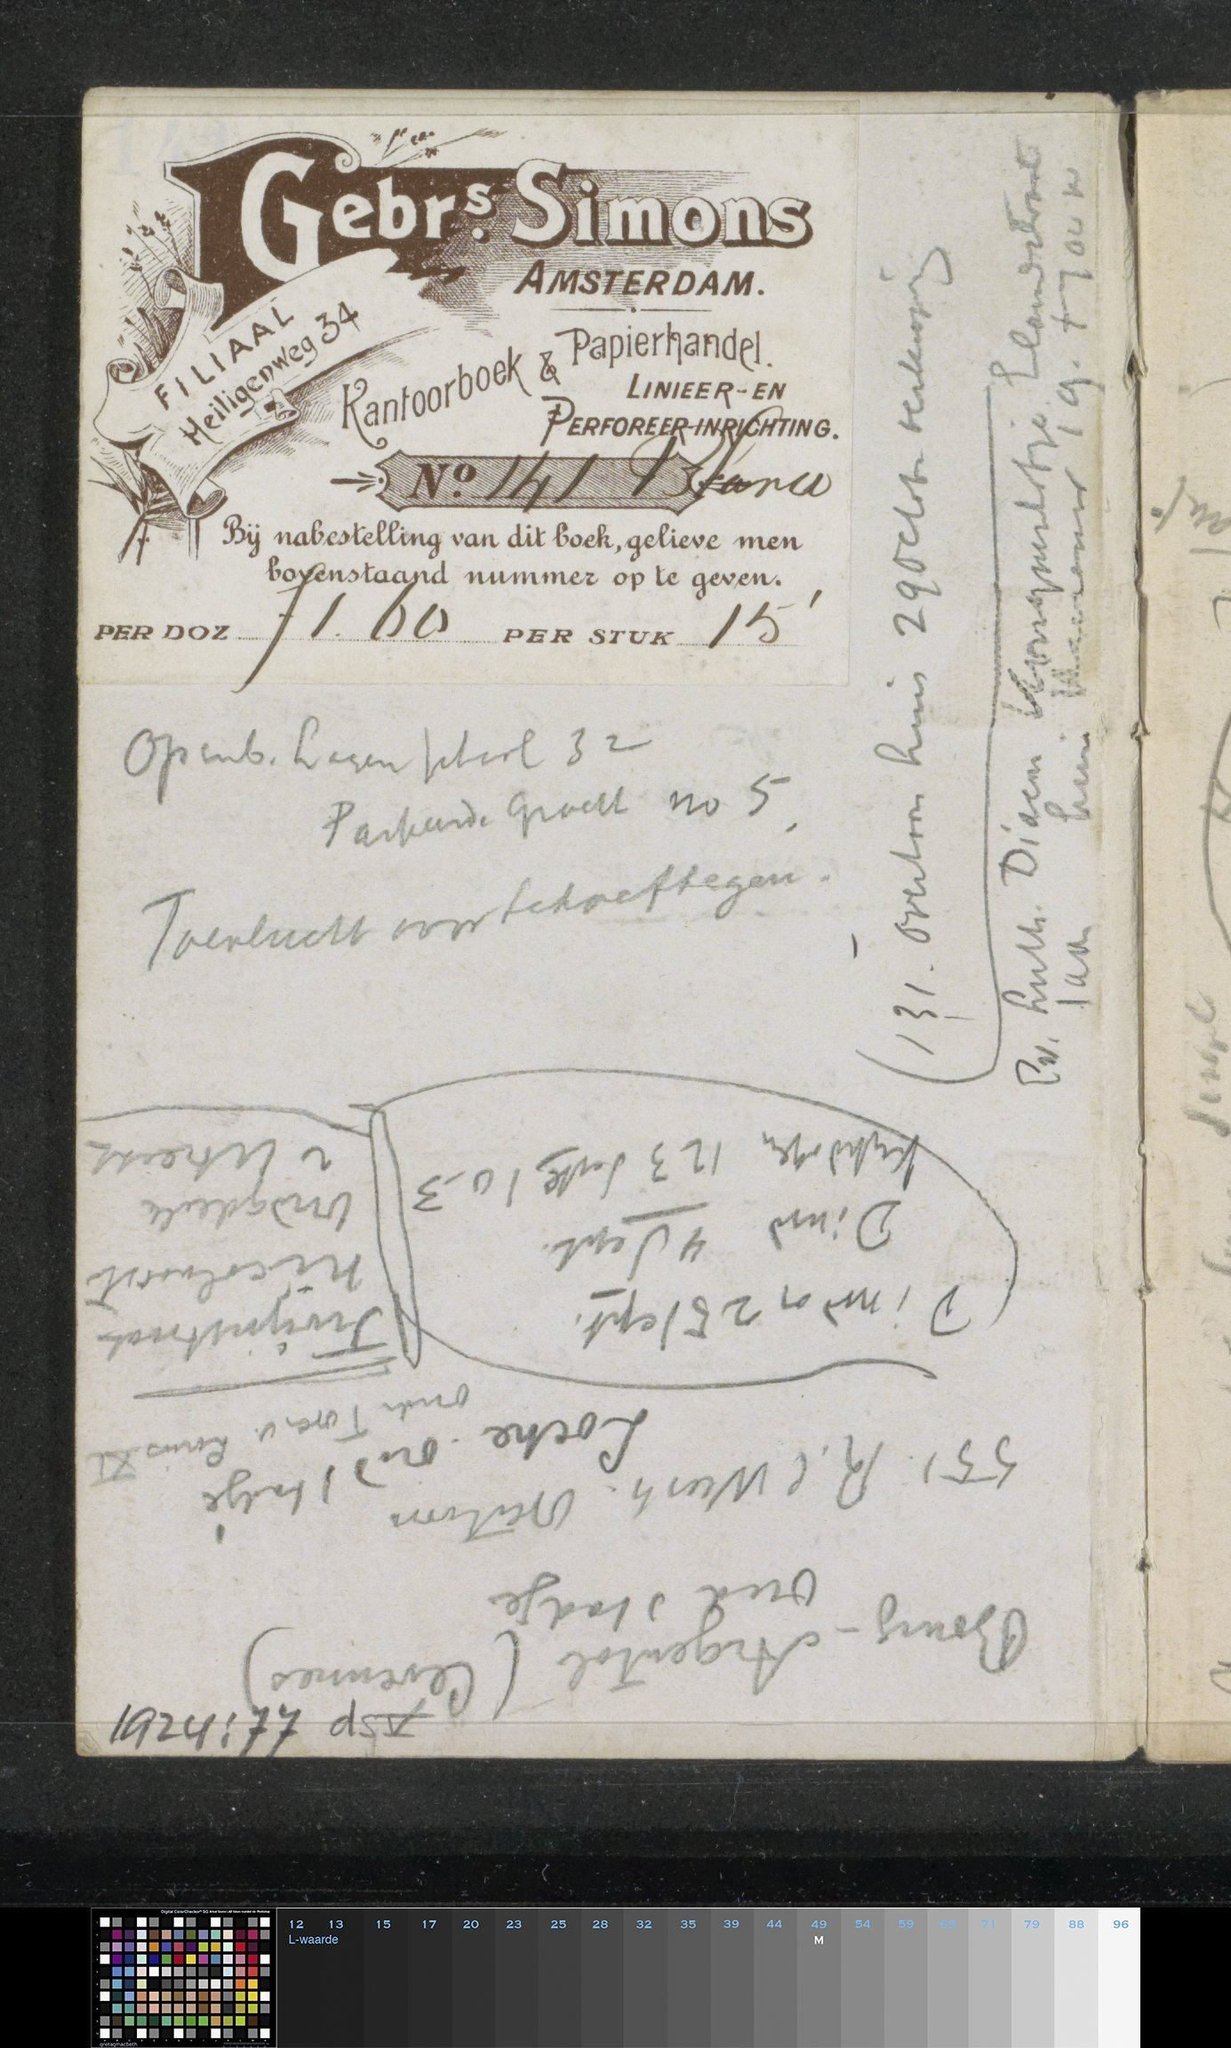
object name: sketchbook leaf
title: Annotaties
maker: george hendrik breitner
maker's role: draughtsman, painter, print maker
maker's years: 1857-1923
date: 1886-1903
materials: paper, pencil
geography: amsterdam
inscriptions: annotation: ‘Dinsdag 25 Sept./ Dinsd 4 Sept./ Kerkdagen 123 [...]’, annotation: ‘Openb. lagere school 32/ Parkeerde[?] Gracht no 5/ Toevlucht voor schoeftegen[?]’, annotation: ‘Twijnstraat/ Nicolaasstr/ oud gedeelte/ v Utrecht’, retailer's mark: ‘Gebrs. Simons/ Amsterdam./ Filiaal/ Heiligenweg 34/ Kantoorboek & Papierhandel./ Linieer- en Perforeer-inrichting./ No. 141 Blanco/ Bij nabestelling van dit boek, gelieve men/ bovenstaand nummer op te geven. / per doz f 1.60 per stuk 15’, annotation: ‘551 R.C Weesh. Overtoom/ Loche [sic] oud stadje/ onder Toren v. Louis XI’, annotation: ‘131. Overtoom huis 290[...] verkooping/ [...] Luth. Diaem[?] K[...]hofje Elandstraat/ huis [...] 19. trouw’, annotation: ‘Bourg-Argental (Cevennes)/ oud stadje’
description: Pagina 1, voorste schutblad, uit een schetsboek met 46 bladen.